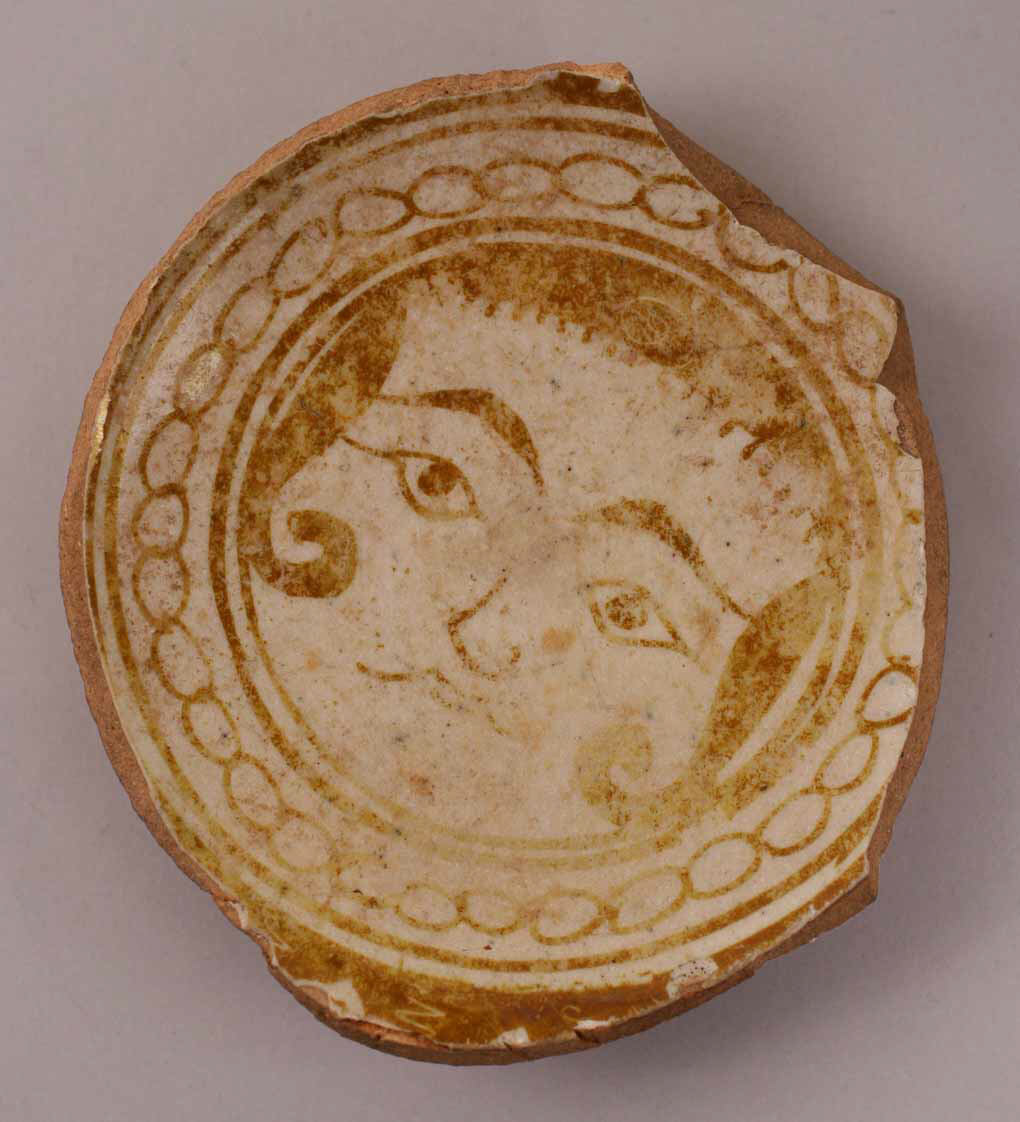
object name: ceramic fragment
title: Fragment of a Dish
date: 1101-1300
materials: earthenware, glaze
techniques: luster painting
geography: egypt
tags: faces